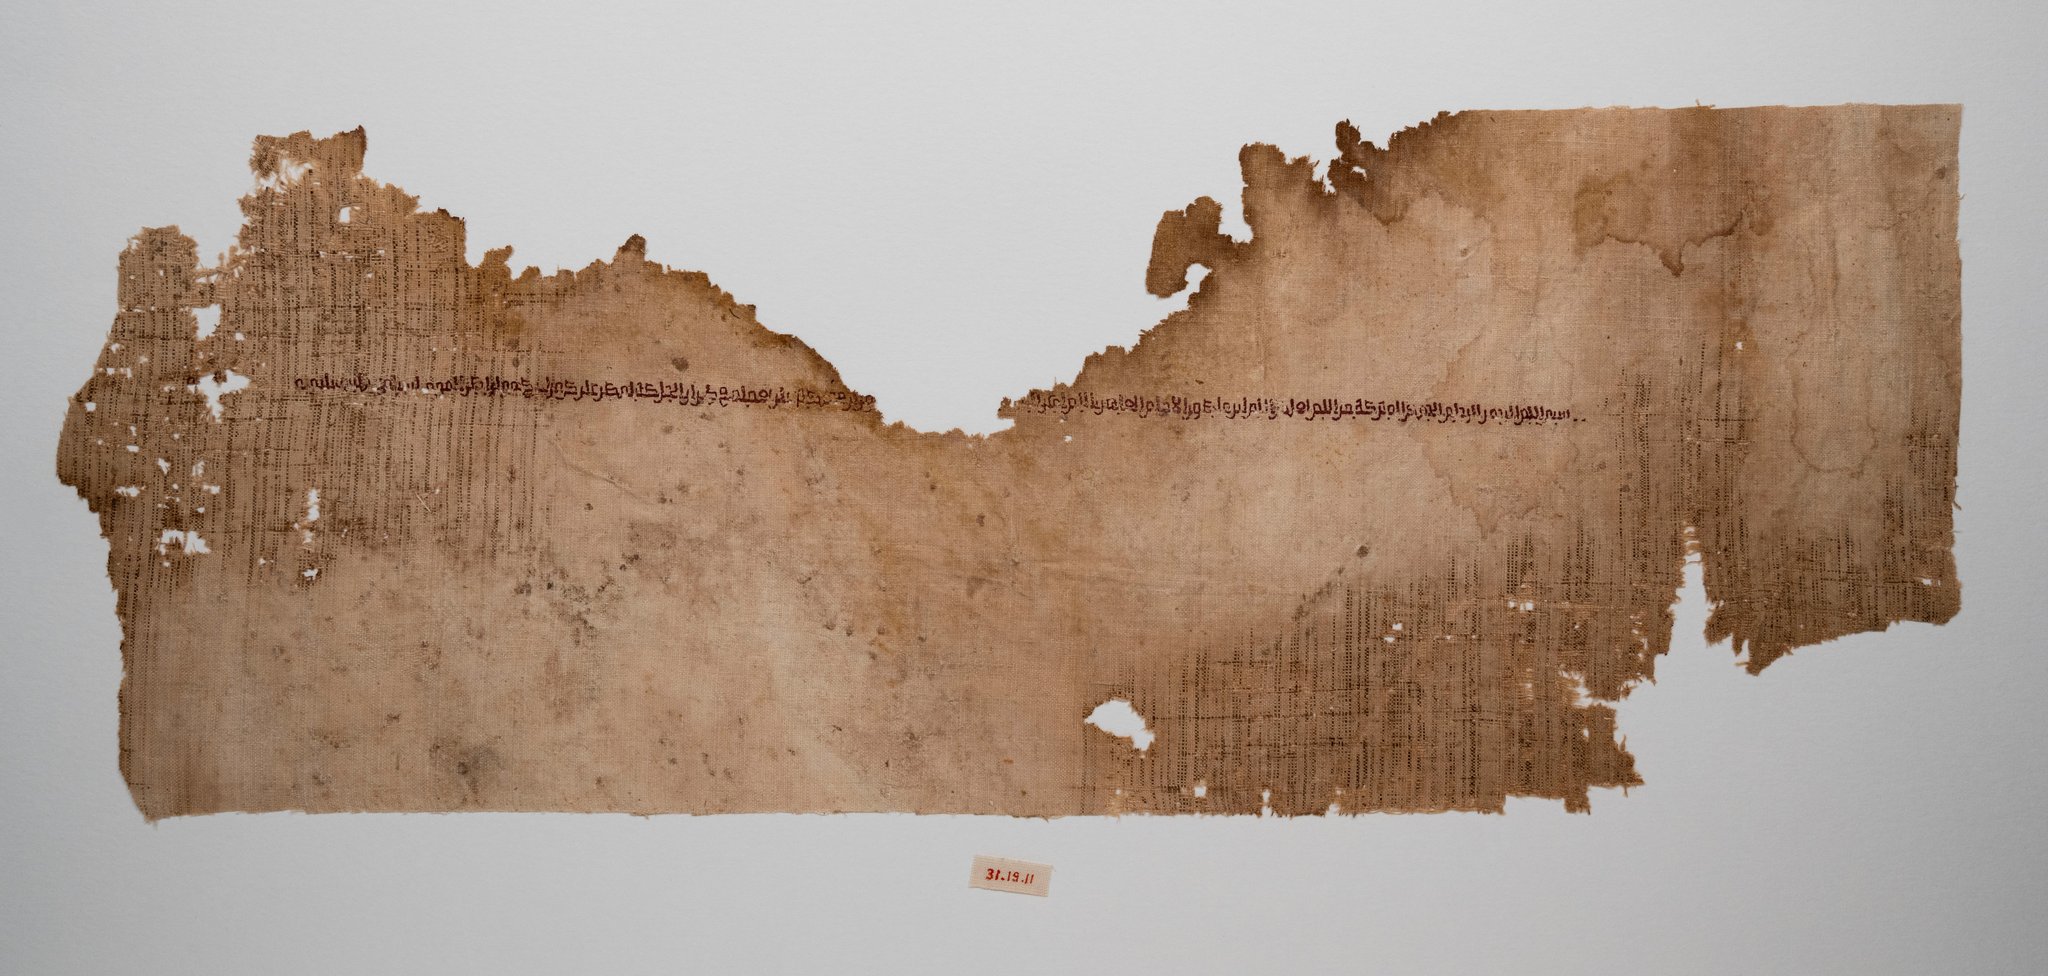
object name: textile fragment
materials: linen, silk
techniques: embroidery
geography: egypt